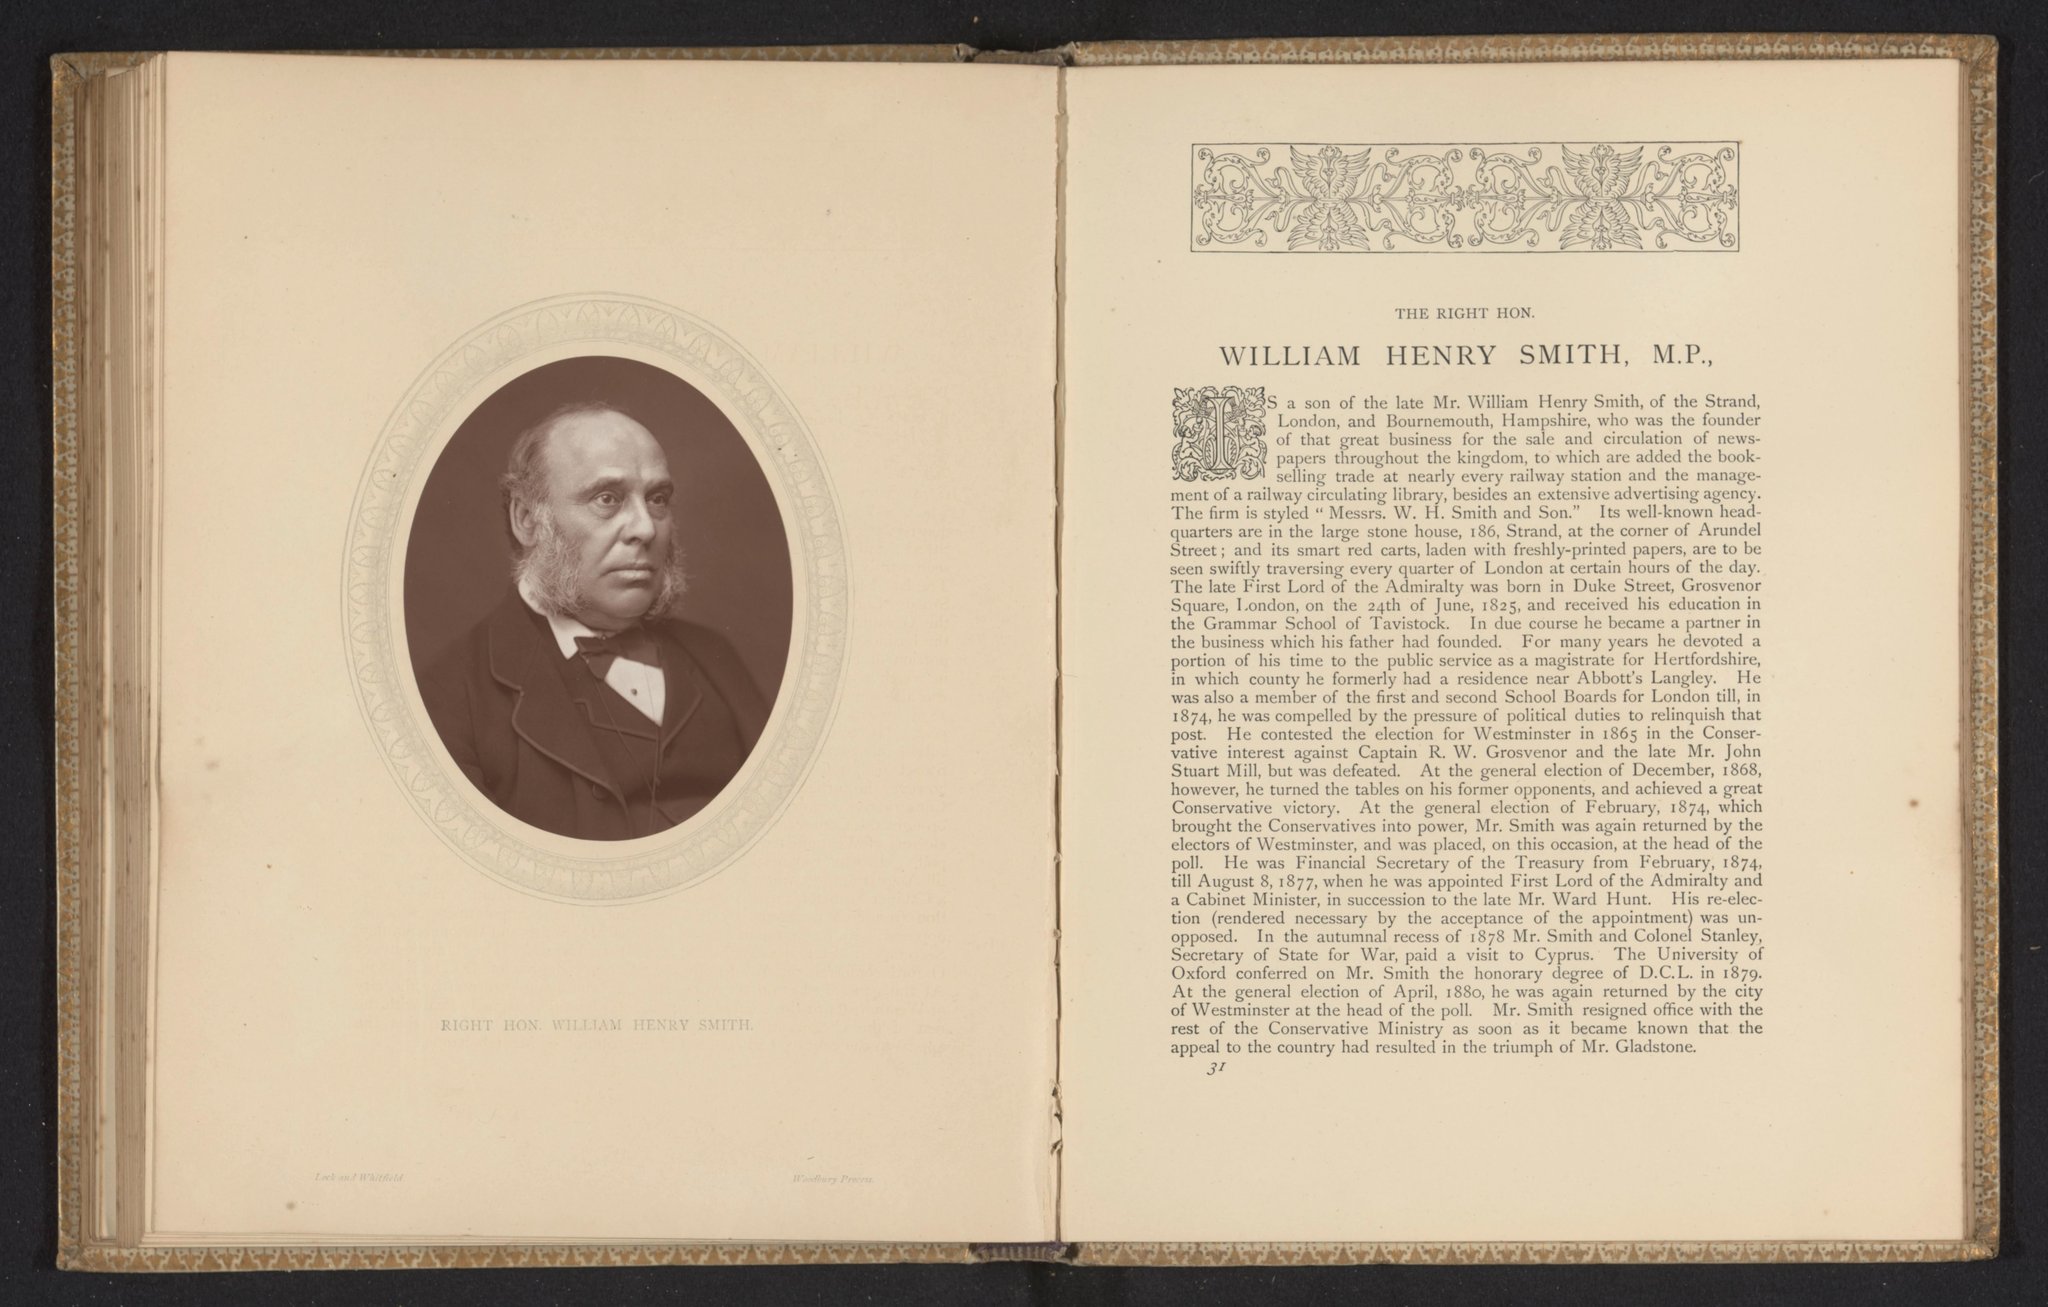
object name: photomechanical print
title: Right hon. William Henry Smith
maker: Anonymous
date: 1876-1881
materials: paper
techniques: woodburytype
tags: historical persons (portraits and scenes from the life) (+ (full) bust portrait), book-shop, bookseller